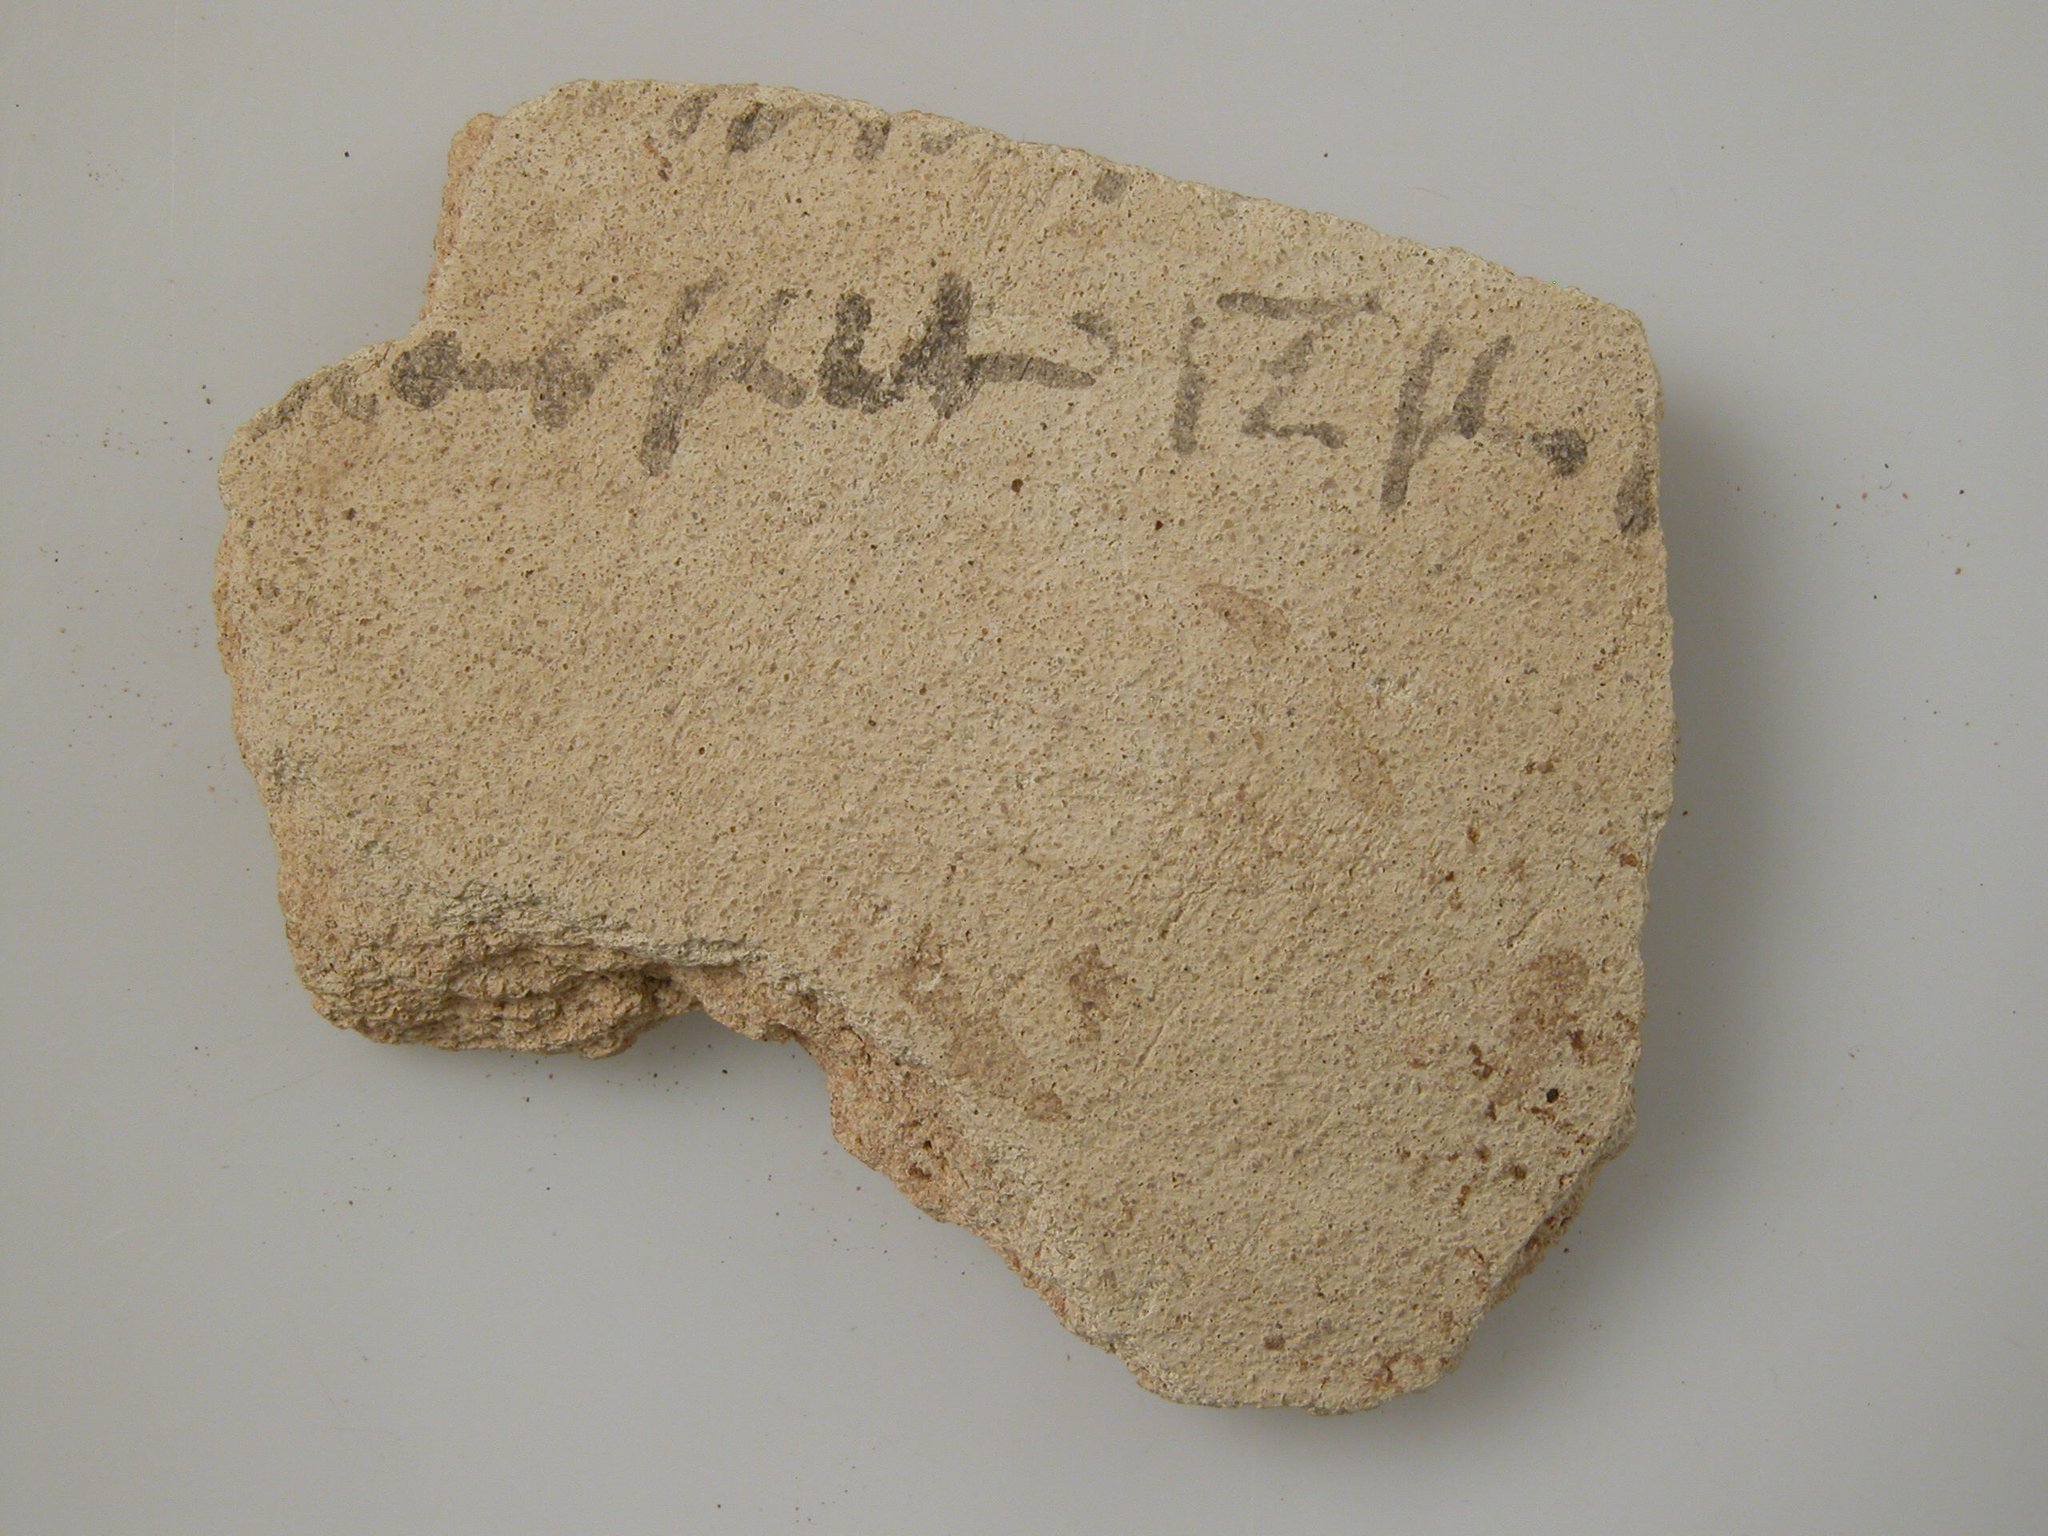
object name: ostrakon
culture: coptic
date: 301-700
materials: ink, pottery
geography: egypt